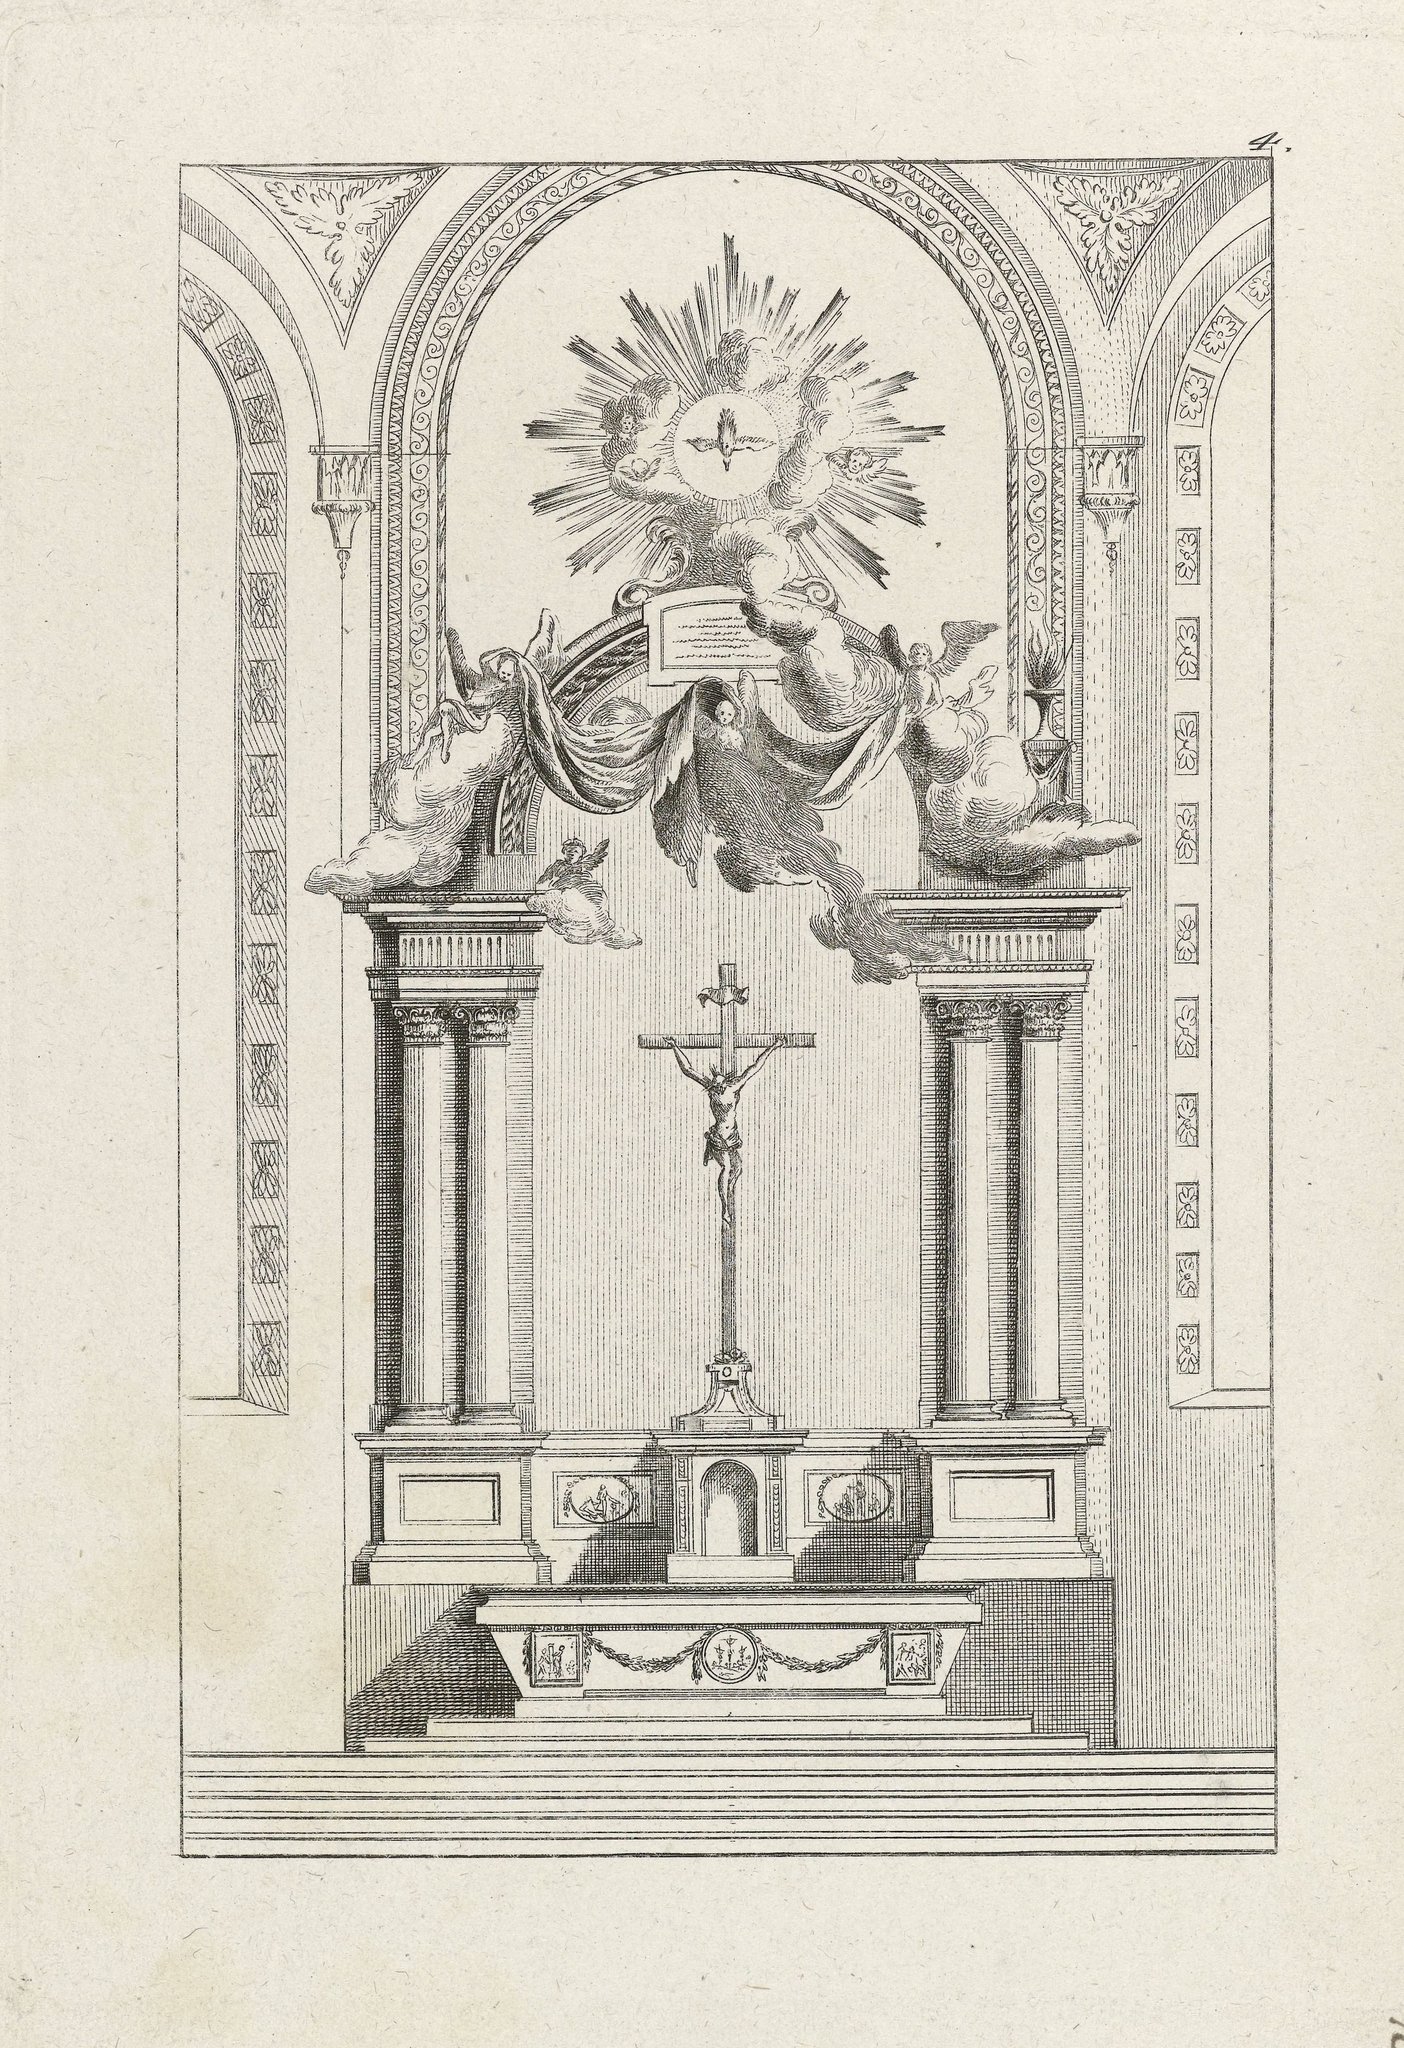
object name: print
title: VI Cahier des Menuisiers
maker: johann thomas hauer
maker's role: print maker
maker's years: 1748-1820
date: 1758-1820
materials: paper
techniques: engraving, etching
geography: augsburg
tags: altar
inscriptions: collector's mark: Lugt 2760, collector's mark: Lugt 2228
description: Ontwerp voor een altaar in interieur. Trappen leiden naar het altaar waarop een kruisbeeld staat. Daarboven vier zwevende engelen. Bekroond door een duif in stralenkrans met drie engelenhoofden.